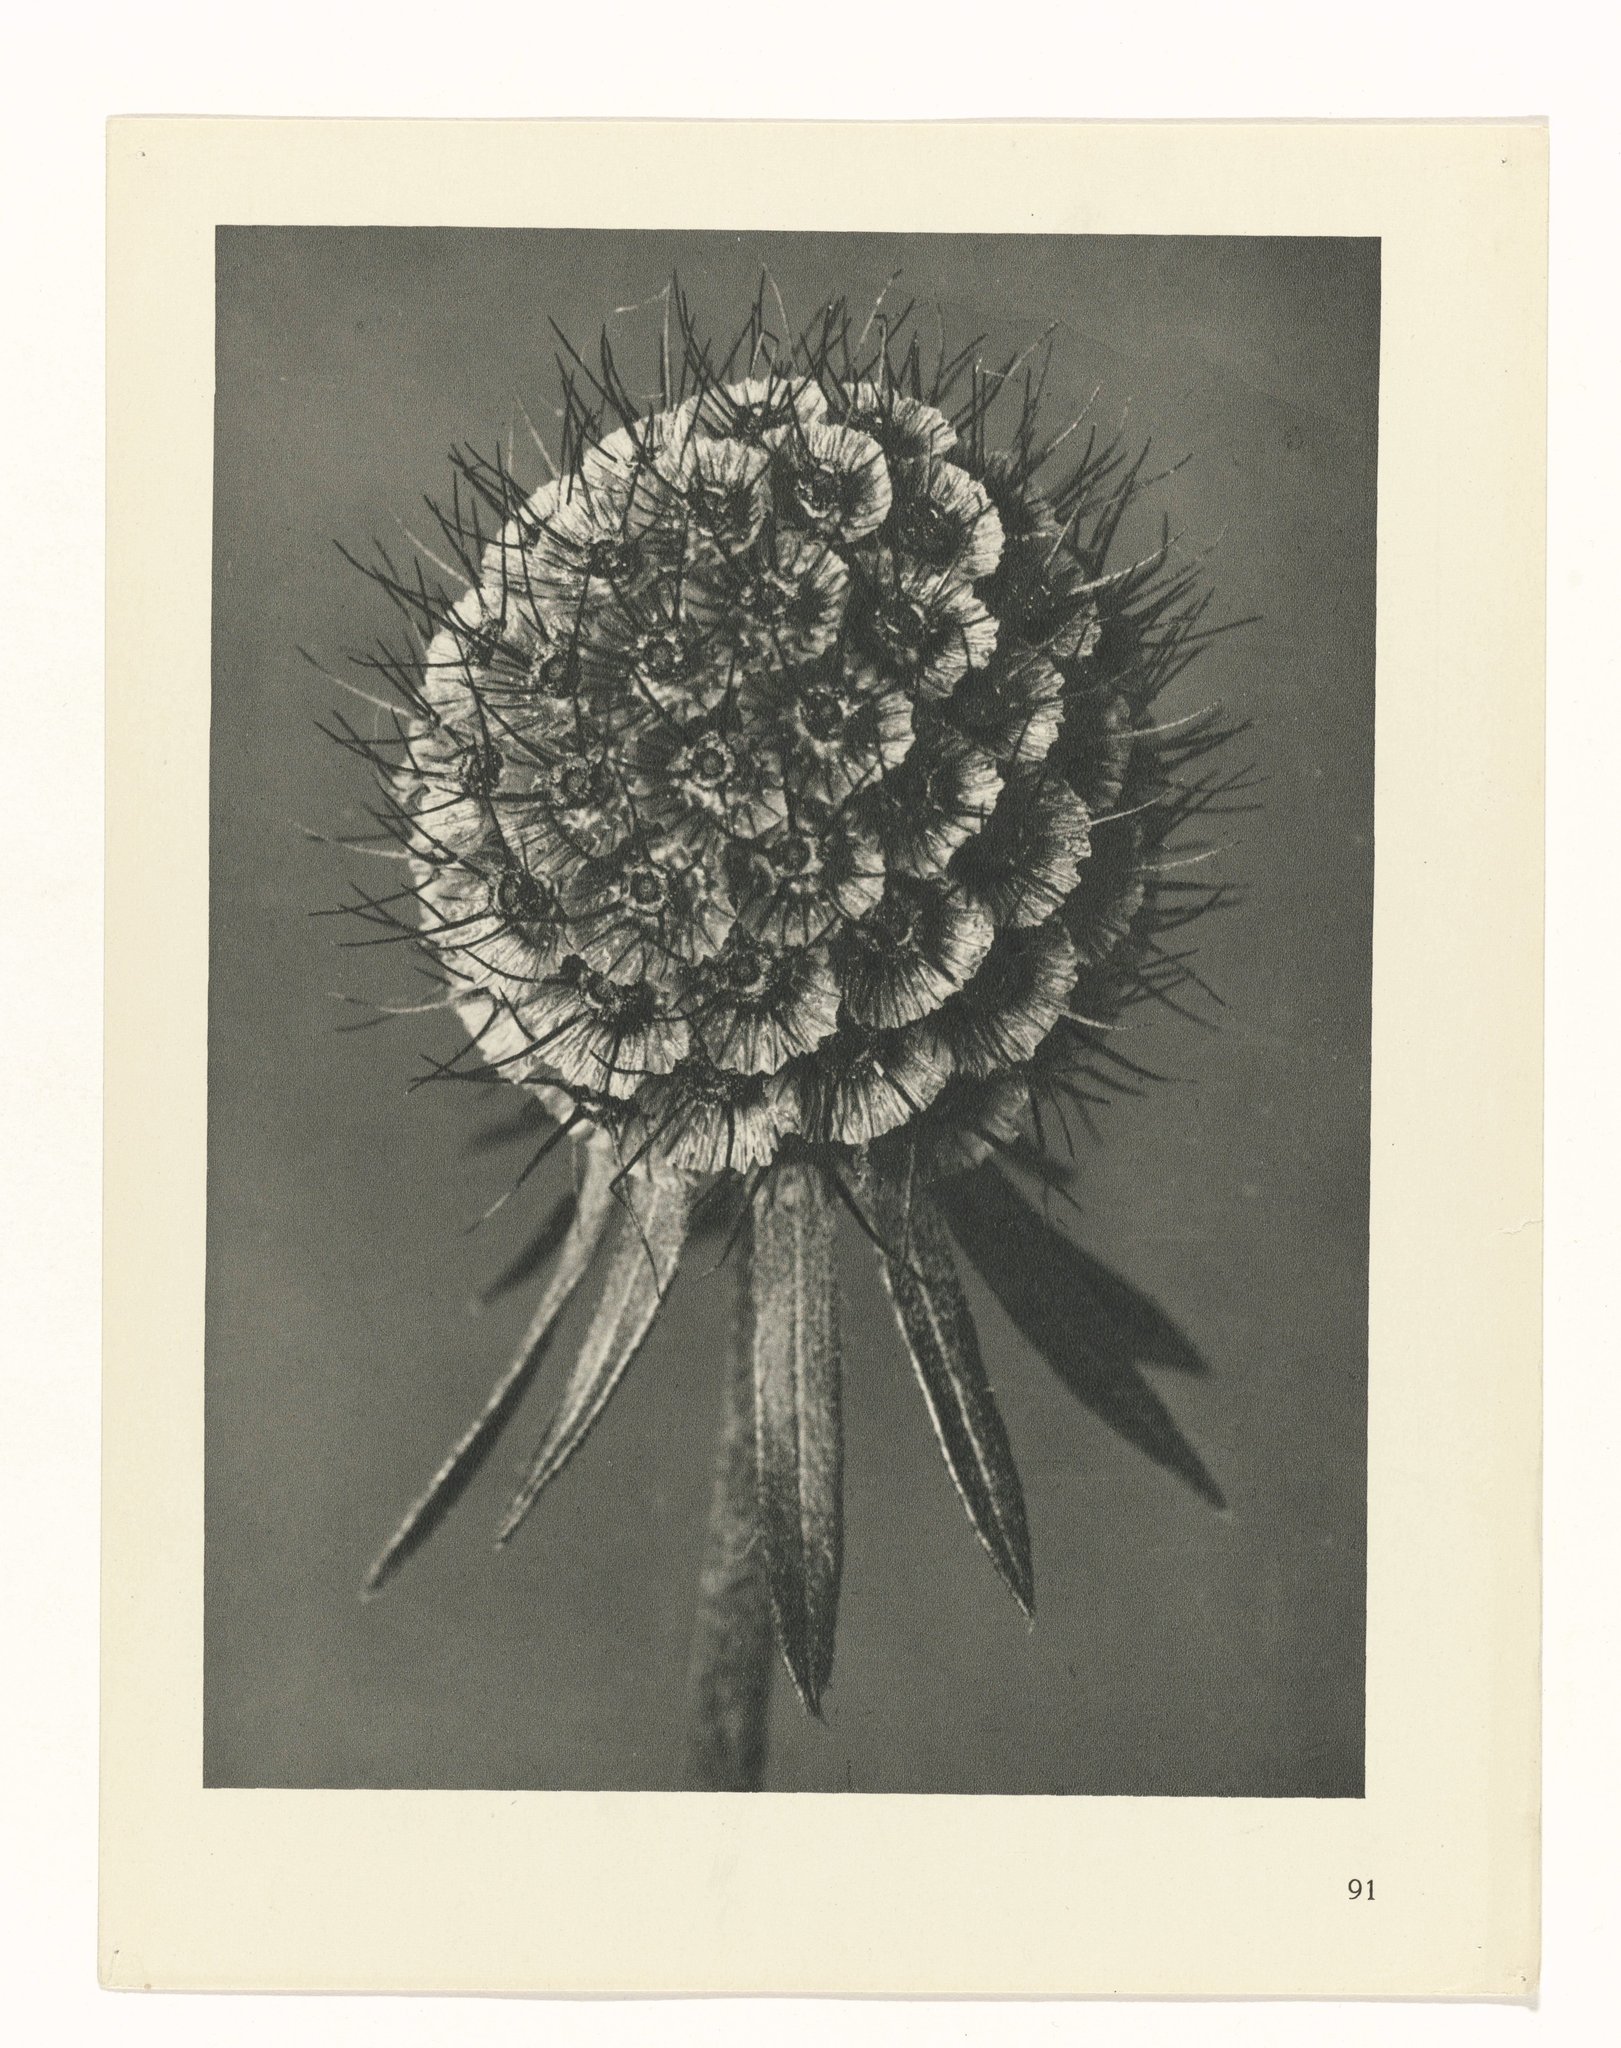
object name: photograph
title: Plantstudie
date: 1928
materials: ink, paper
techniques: rotogravure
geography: berlin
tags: plants (in general)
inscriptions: number: ‘91’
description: facher Vergrößerung. Afkomstig uit losbladige uitgave.